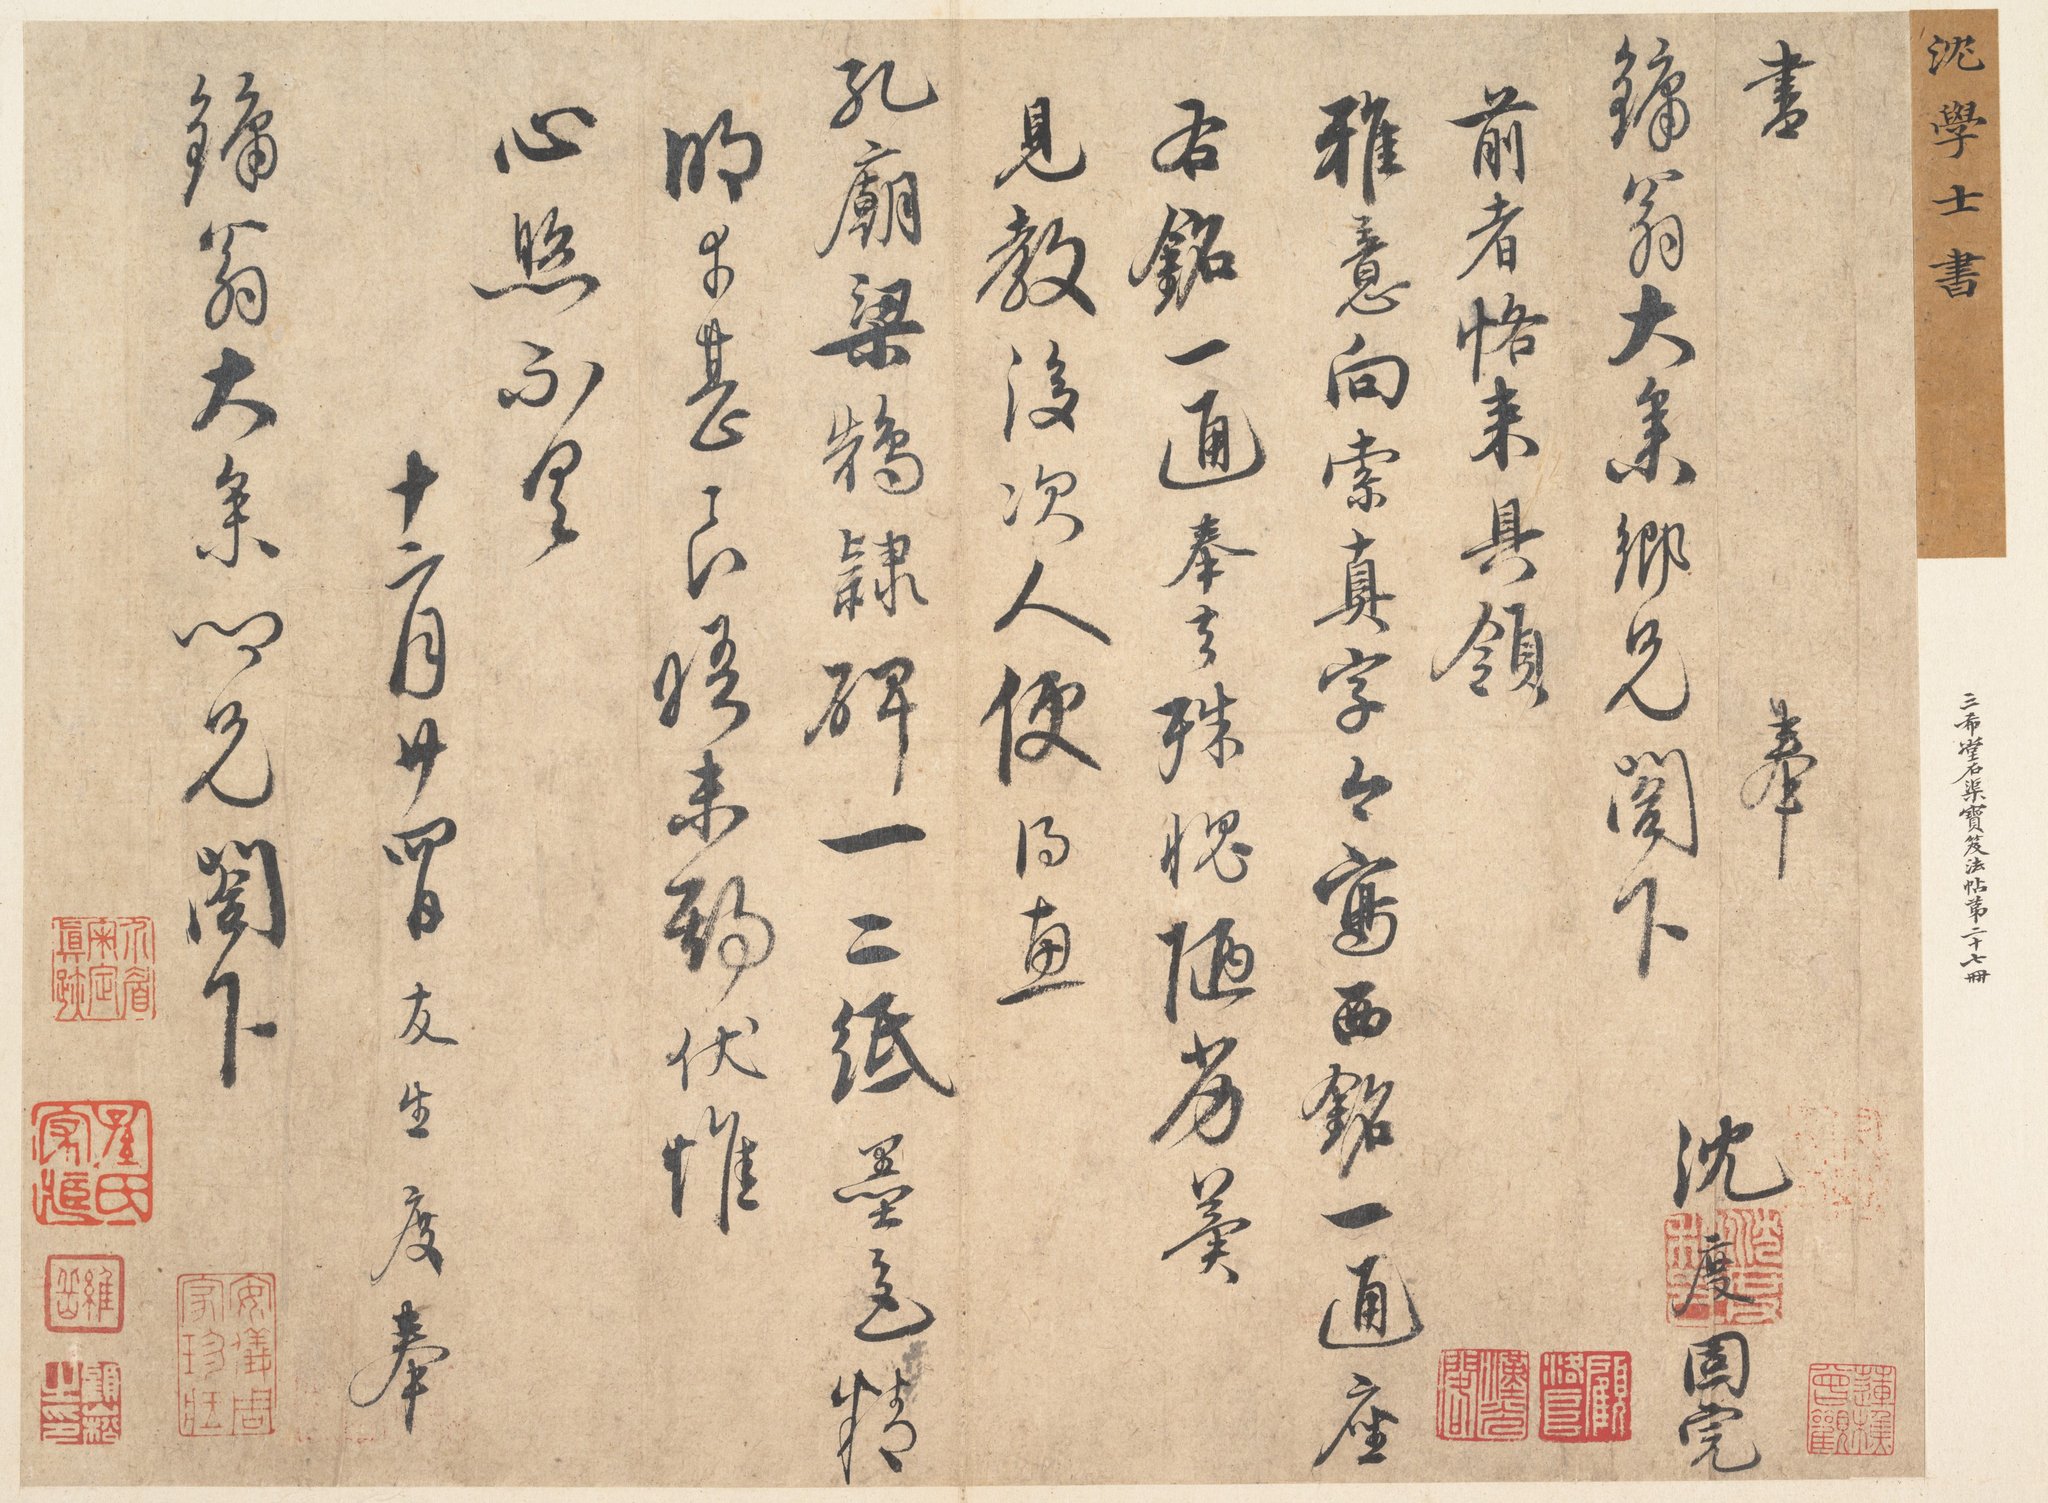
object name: album leaf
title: Letter to Liang Zhongren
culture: chinese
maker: shen du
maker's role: artist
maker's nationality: chinese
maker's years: 1357-1434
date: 1357-1434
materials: ink, paper